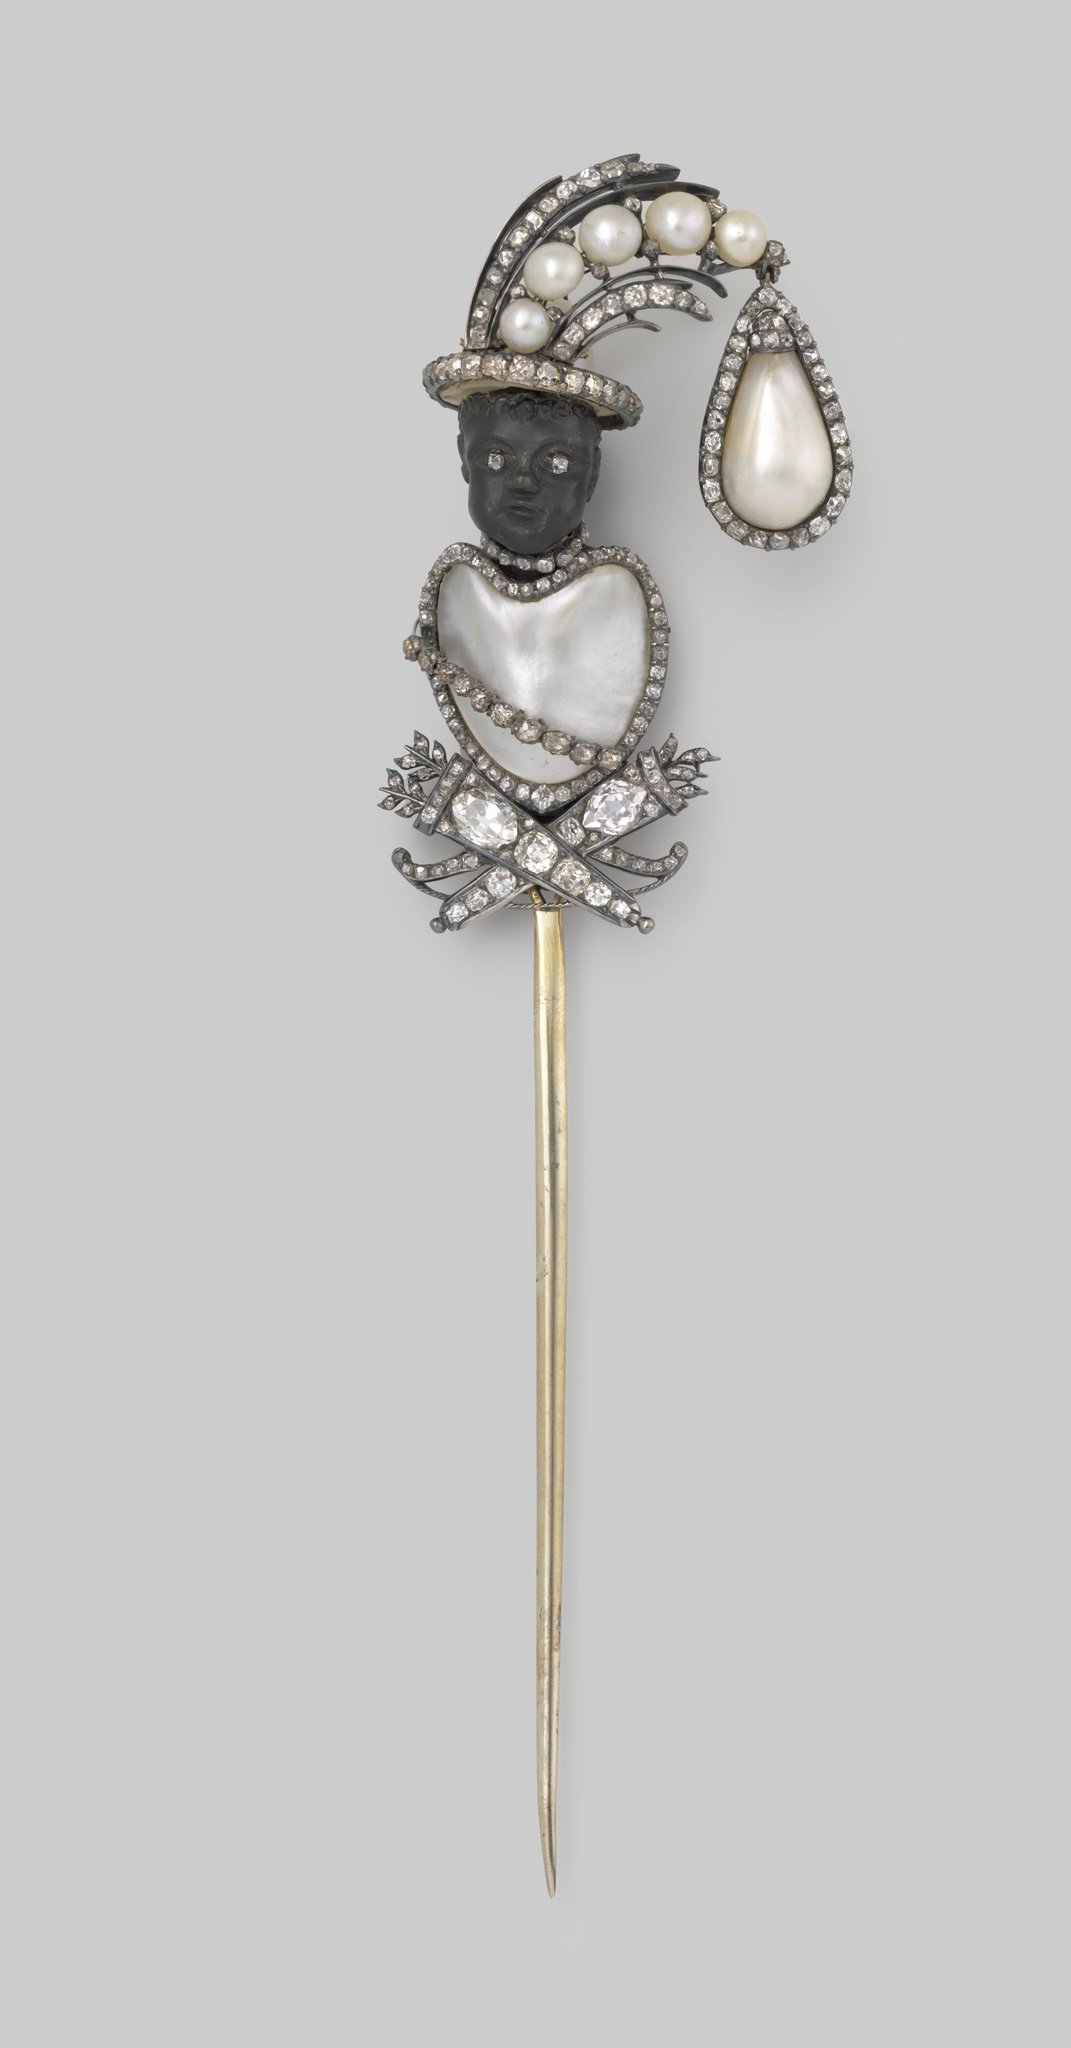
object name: jewellery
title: Steekspeld van verguld zilver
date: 1600-1800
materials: diamond, pearl, silver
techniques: gilding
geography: germany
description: Op de top het borstbeeld van een Moor. Kop en rug zijn uit zwart gesteente gesneden. De borst bestaat uit een barokparel, waaronder twee gekruiste pijlkokers, bezet met diamanten. De hoed is gevormd uit een barokparel met diamanten en parels en een grote, door diamante omlijste parel.